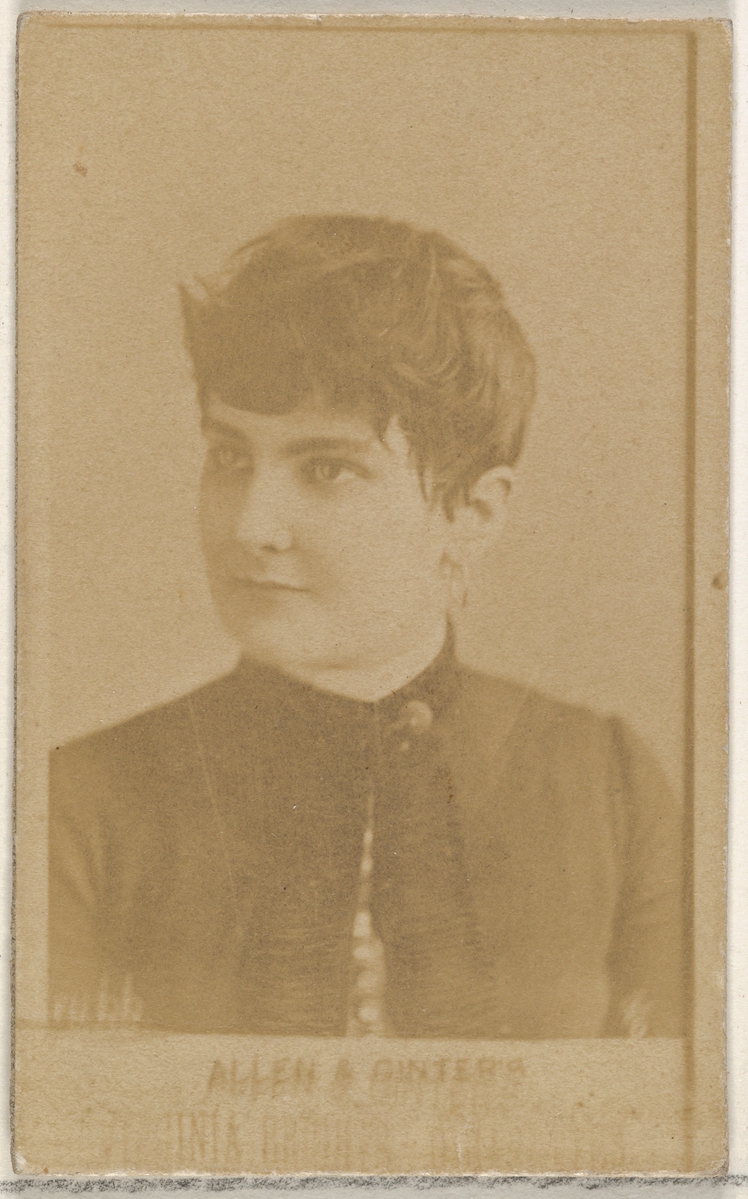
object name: photograph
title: From the Actors and Actresses series (N45, Type 5) for Virginia Brights Cigarettes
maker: allen & ginter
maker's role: publisher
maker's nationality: american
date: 1888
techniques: albumen silver print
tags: portraits,women,actresses